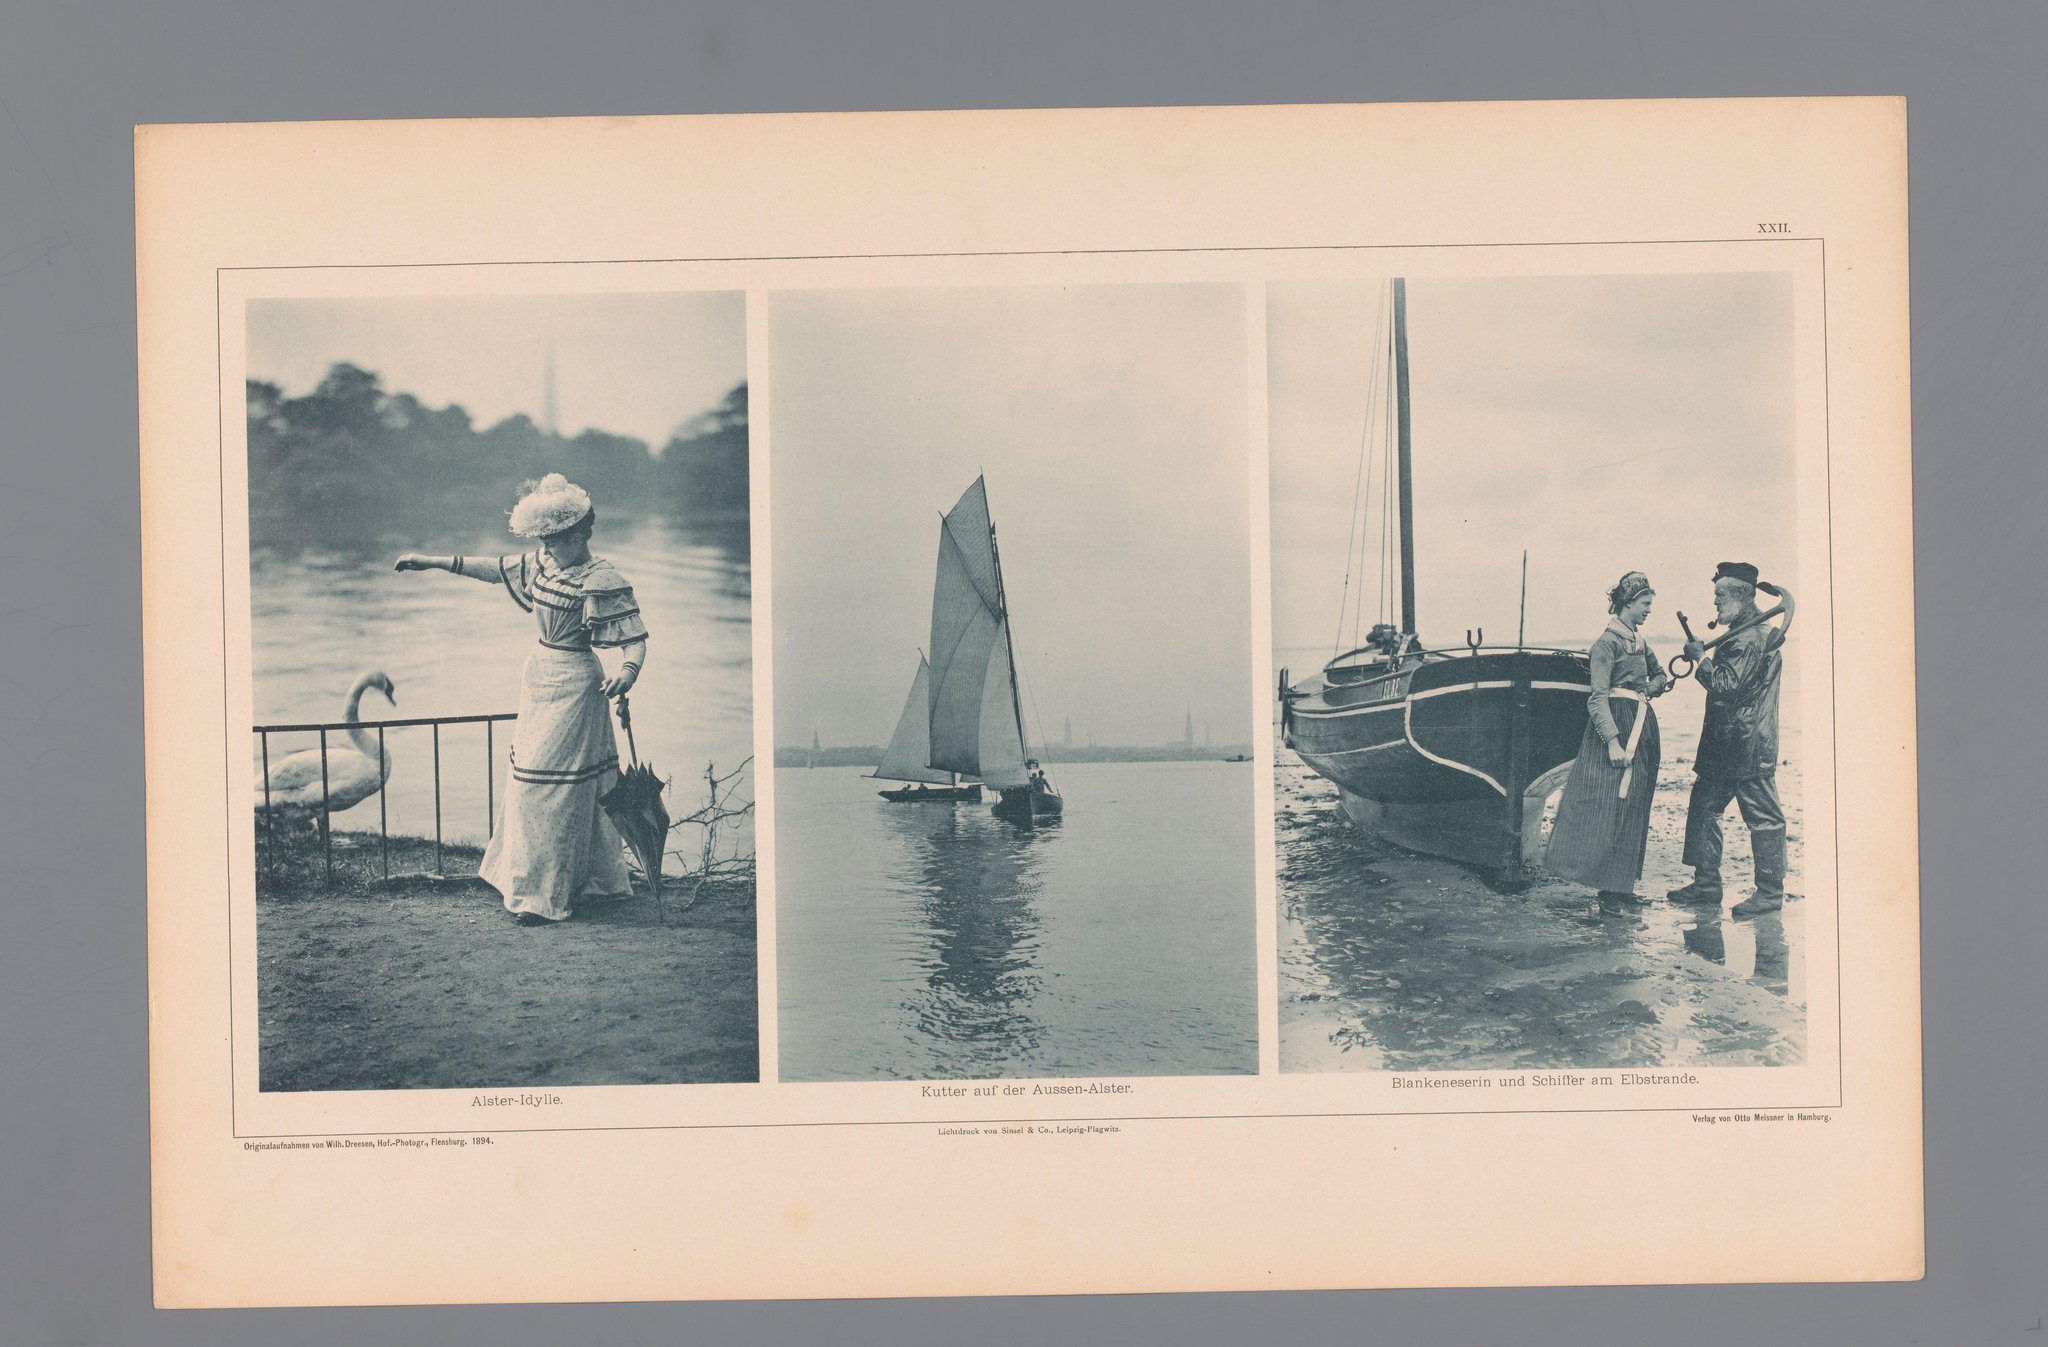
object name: photomechanical print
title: Drie afbeeldingen van een vrouw die een zwaan voert, een zeilboot en een schipper en een vrouw voor een zeilboot op de oever van de Elbe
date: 1894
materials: paper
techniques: photograph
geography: leipzig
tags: sailing-ship, sailing-boat, river bank (+ landscape with figures, staffage)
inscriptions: inscription: ‘Originalaufnahmen von Wilh. Dreesen, Hof.-Photogr., Flensburg. 1894.’, number: ‘XXII.’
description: Deze prenten maken deel uit van een omslag met 126 prenten op 37 bladen en een tekstblad.